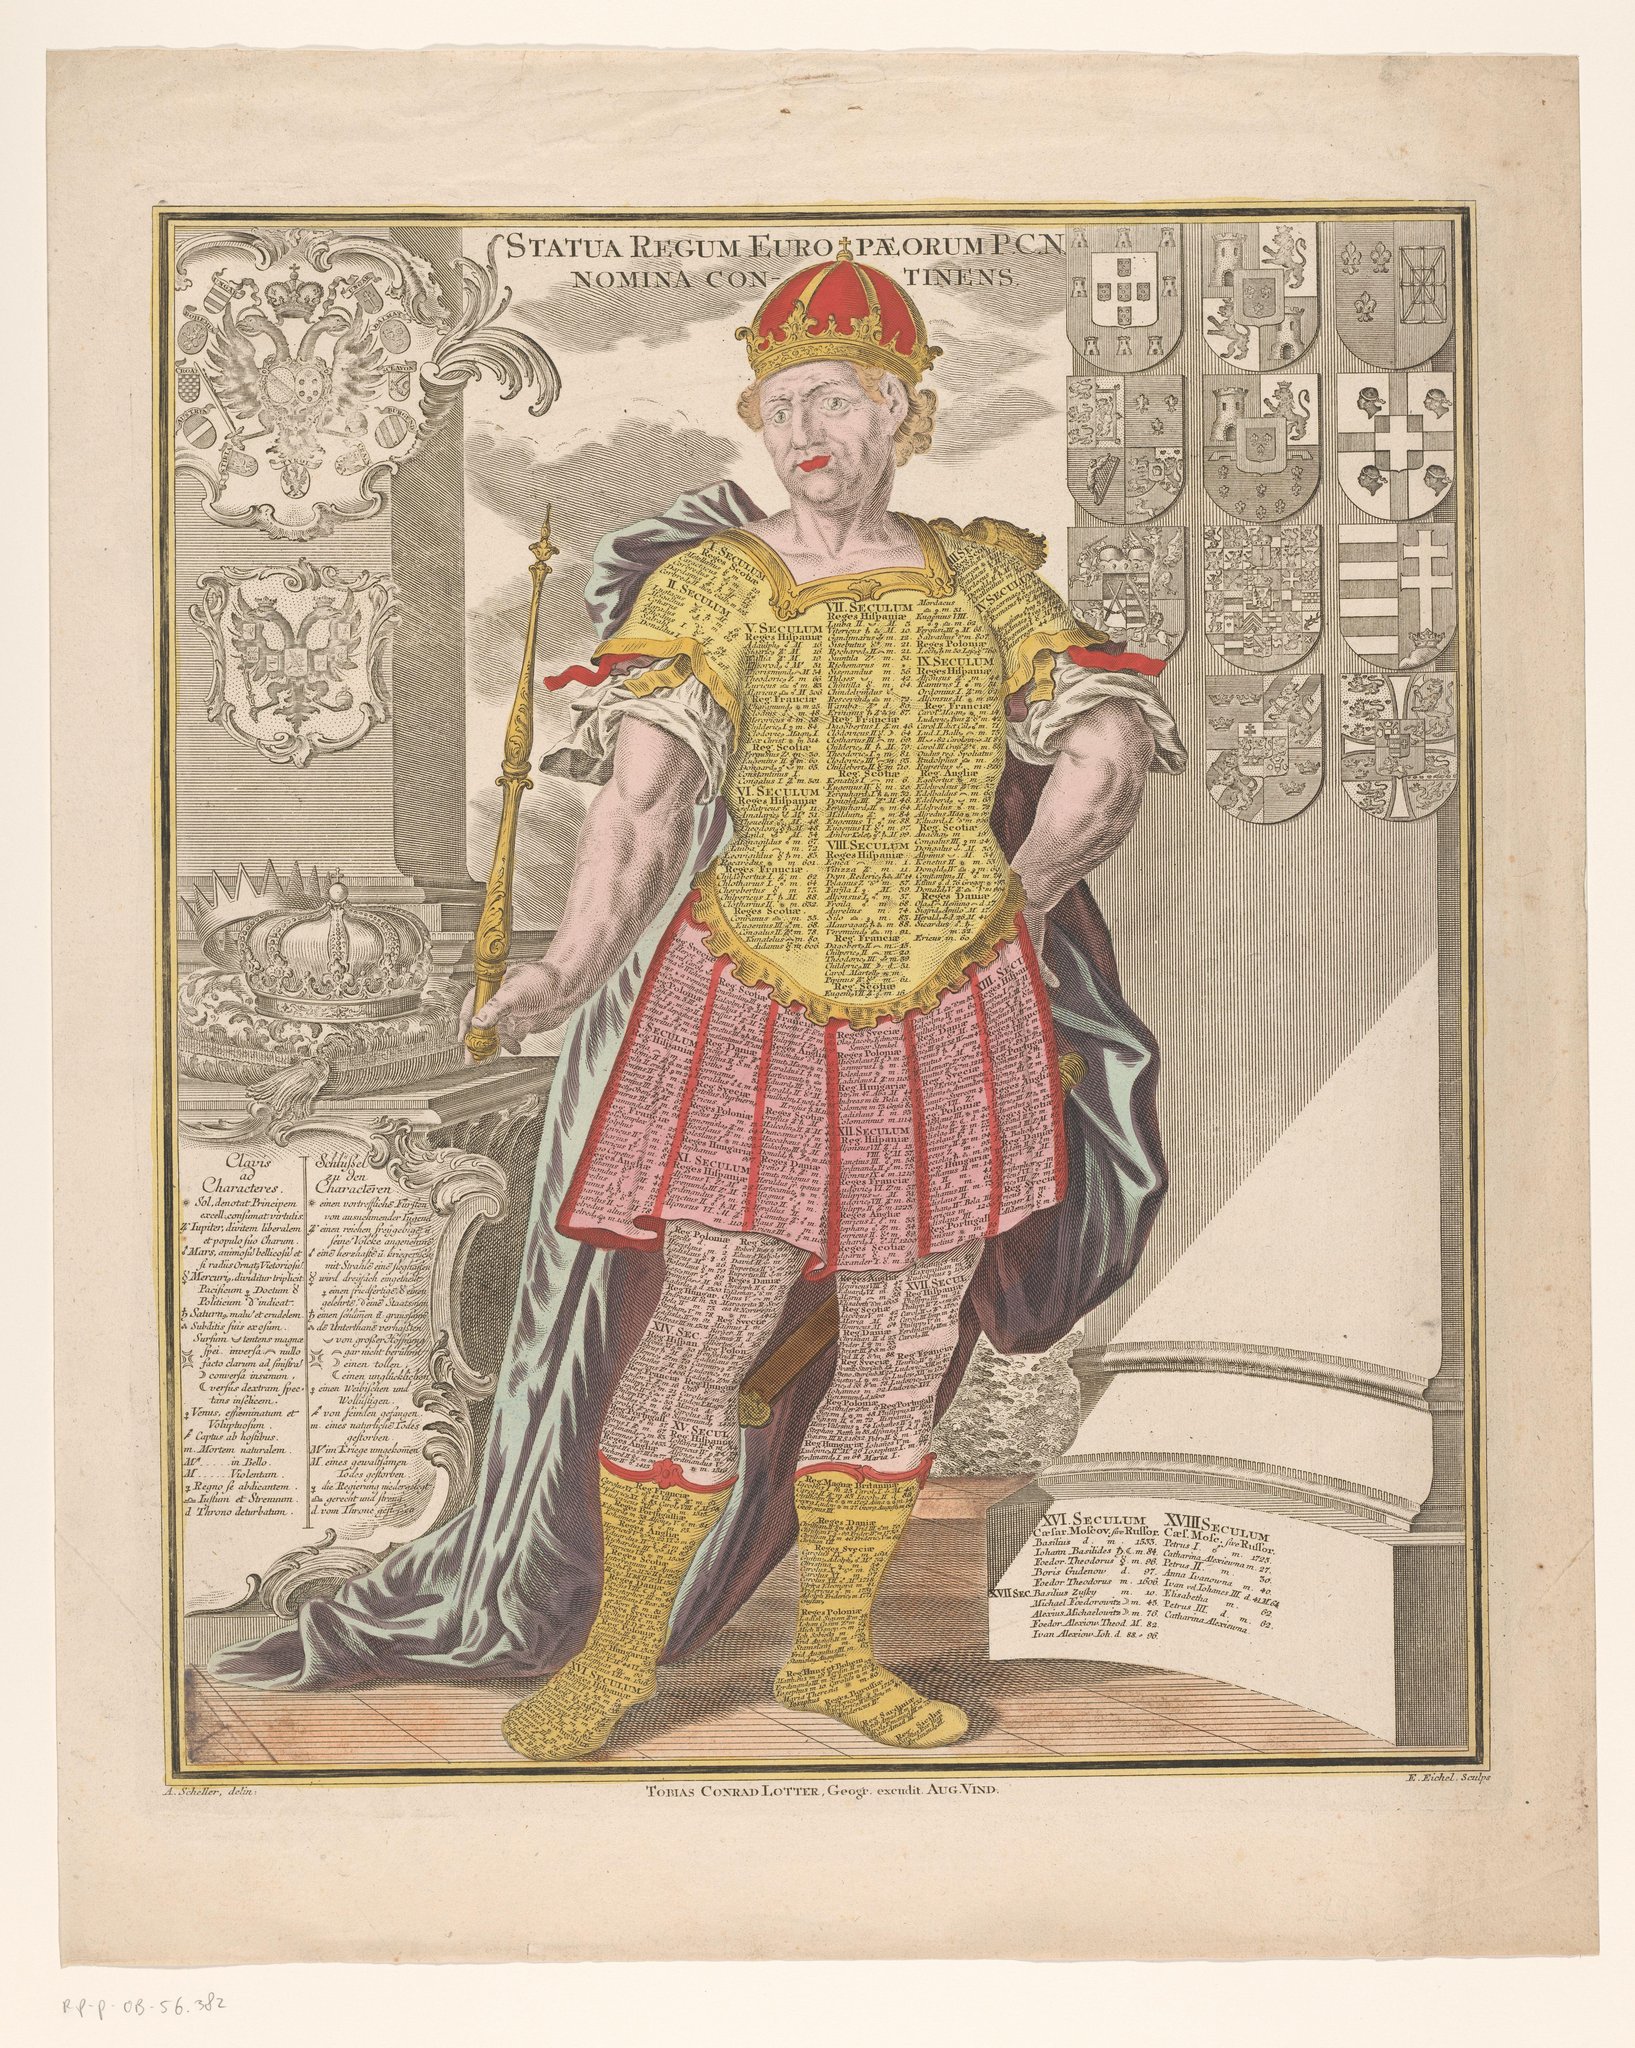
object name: print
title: Statua Regum Europaeorum P.C.N. Nomina Continens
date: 1727-1782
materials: paper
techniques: etching, hand coloring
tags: chronology, history, armorial bearing, heraldry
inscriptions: collector's mark: Lugt 2228